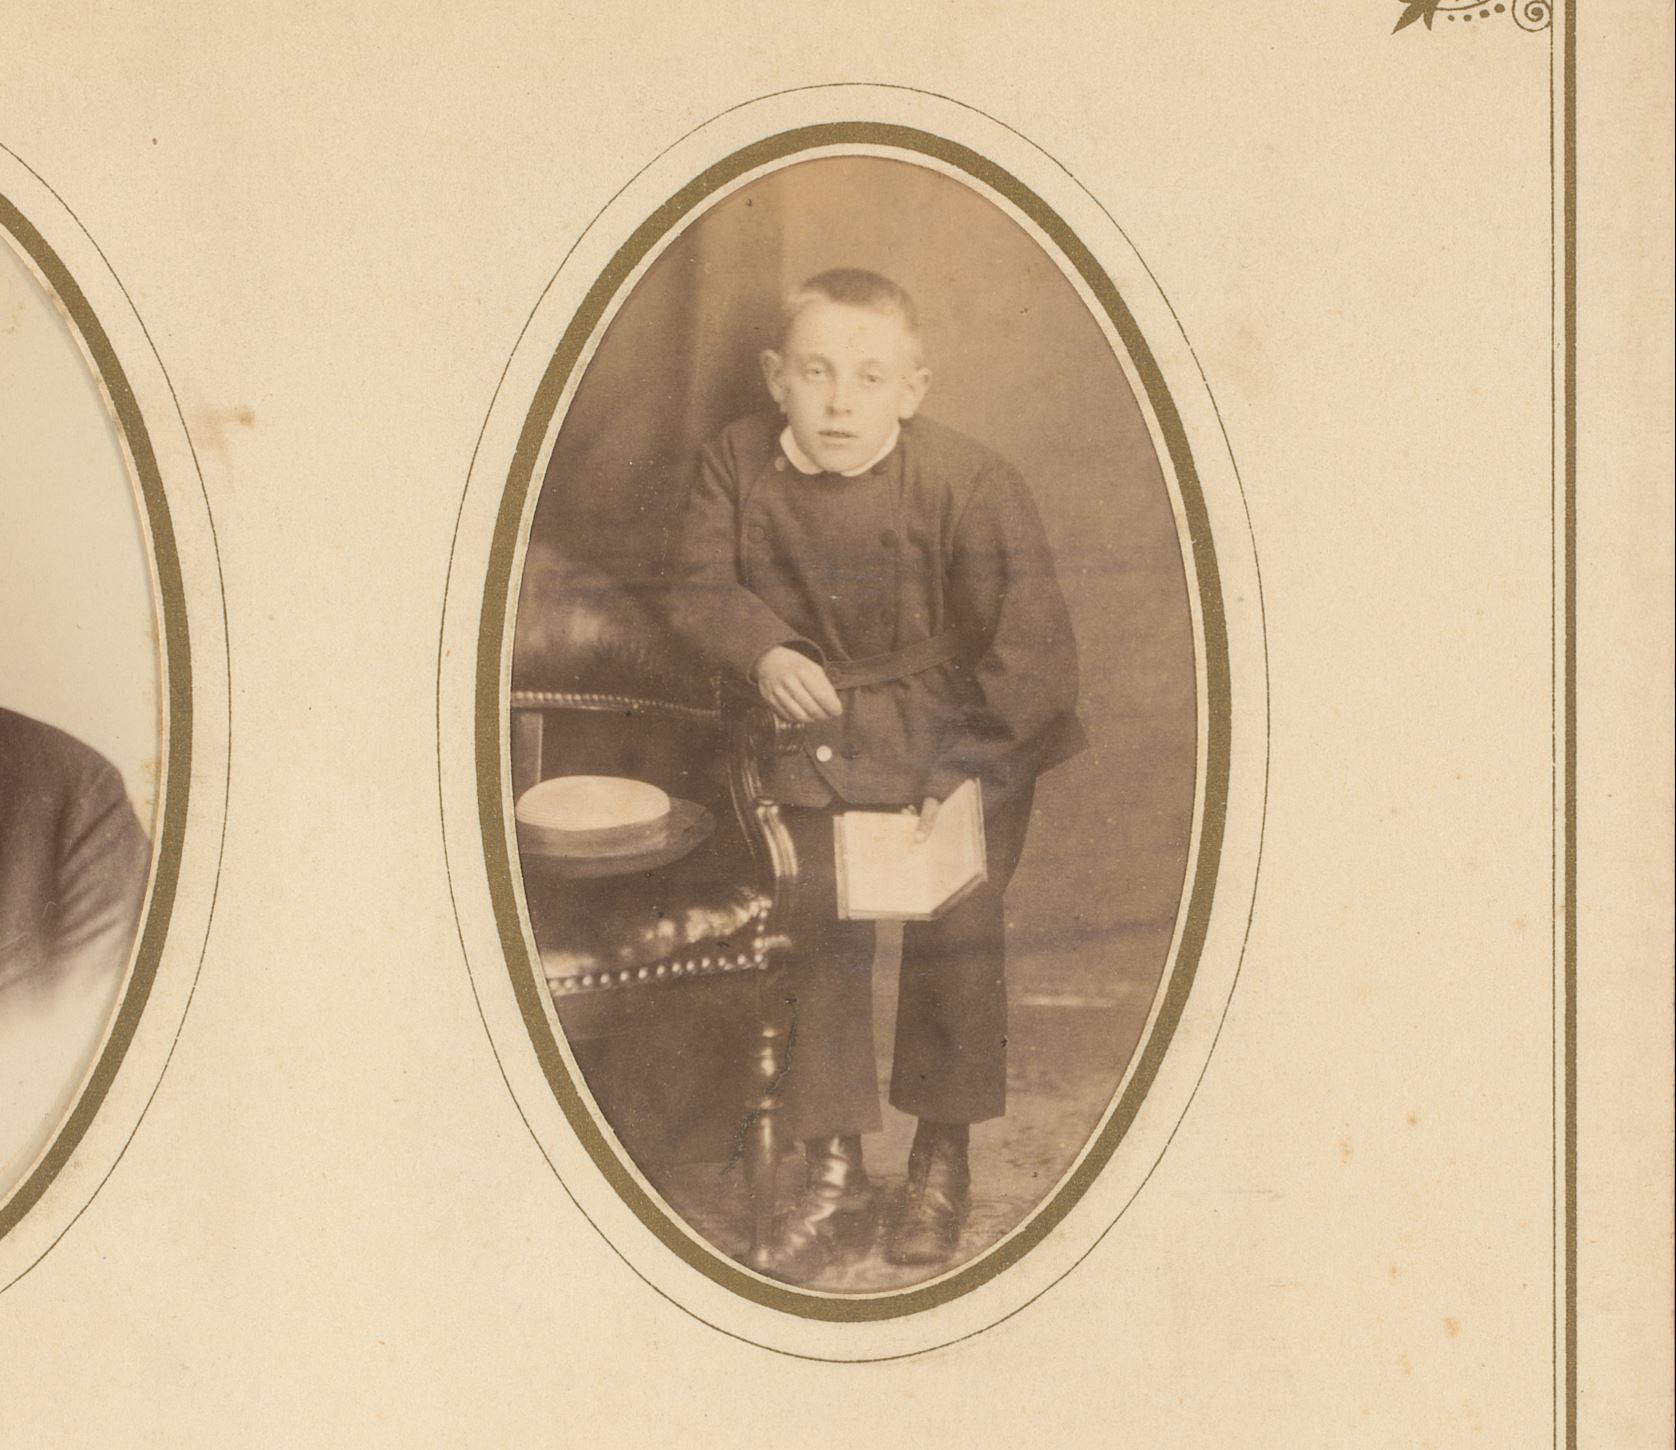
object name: carte de visite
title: Portret van een jongen met open boek in de hand, staand bij een stoel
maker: j.j.d. van geuns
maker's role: fotograaf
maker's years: 1852-1885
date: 1882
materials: cardboard, photographic support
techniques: albumen print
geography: appingedam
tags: boy (child between toddler and youth), historical persons, book - mm - book open, chair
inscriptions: inscription: ‘Photographisch/ Atelier/ van/ J.J.D. van Geuns/ Appingedam./ Salwerderstraat./ Van ieder soort portret kunnen vergrootingen worden/ geleverd.’